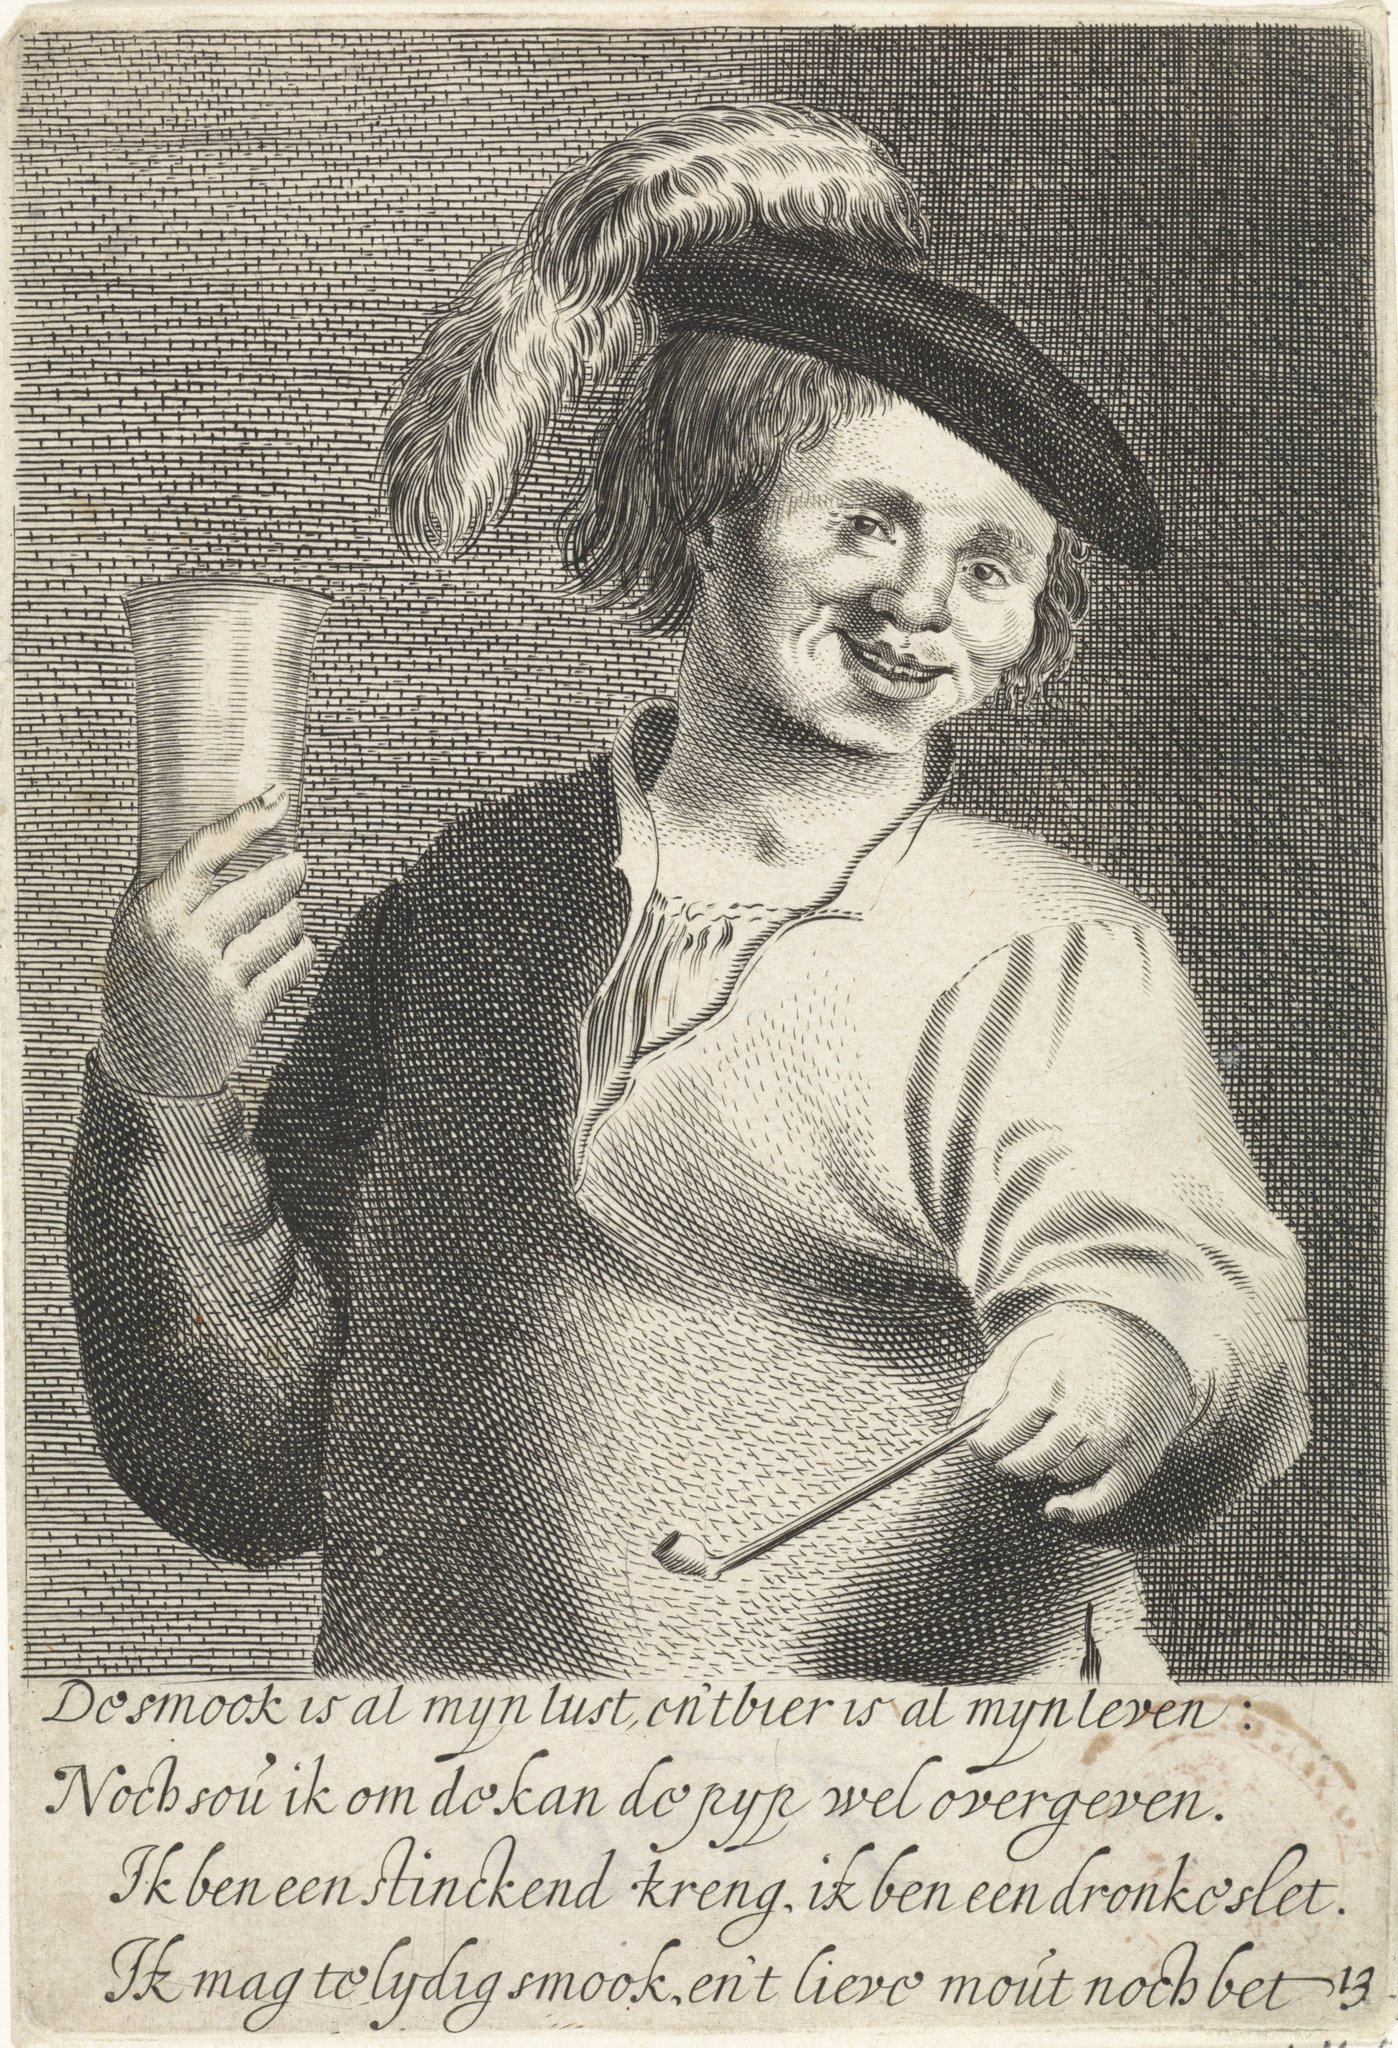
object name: print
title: Spiegel van ijdelheid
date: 1633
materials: paper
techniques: engraving, etching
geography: amsterdam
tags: beer, ale, tobacco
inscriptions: collector's mark: Lugt 240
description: Man met een glas in de ene, en een pijp in de andere hand. De pijp lijkt hij aan de beschouwer te willen overhandigen; hij spreeekt over zijn uiteindelijke voorkeur voor bier boven tabak. Dertiende prent uit een serie van achttien.